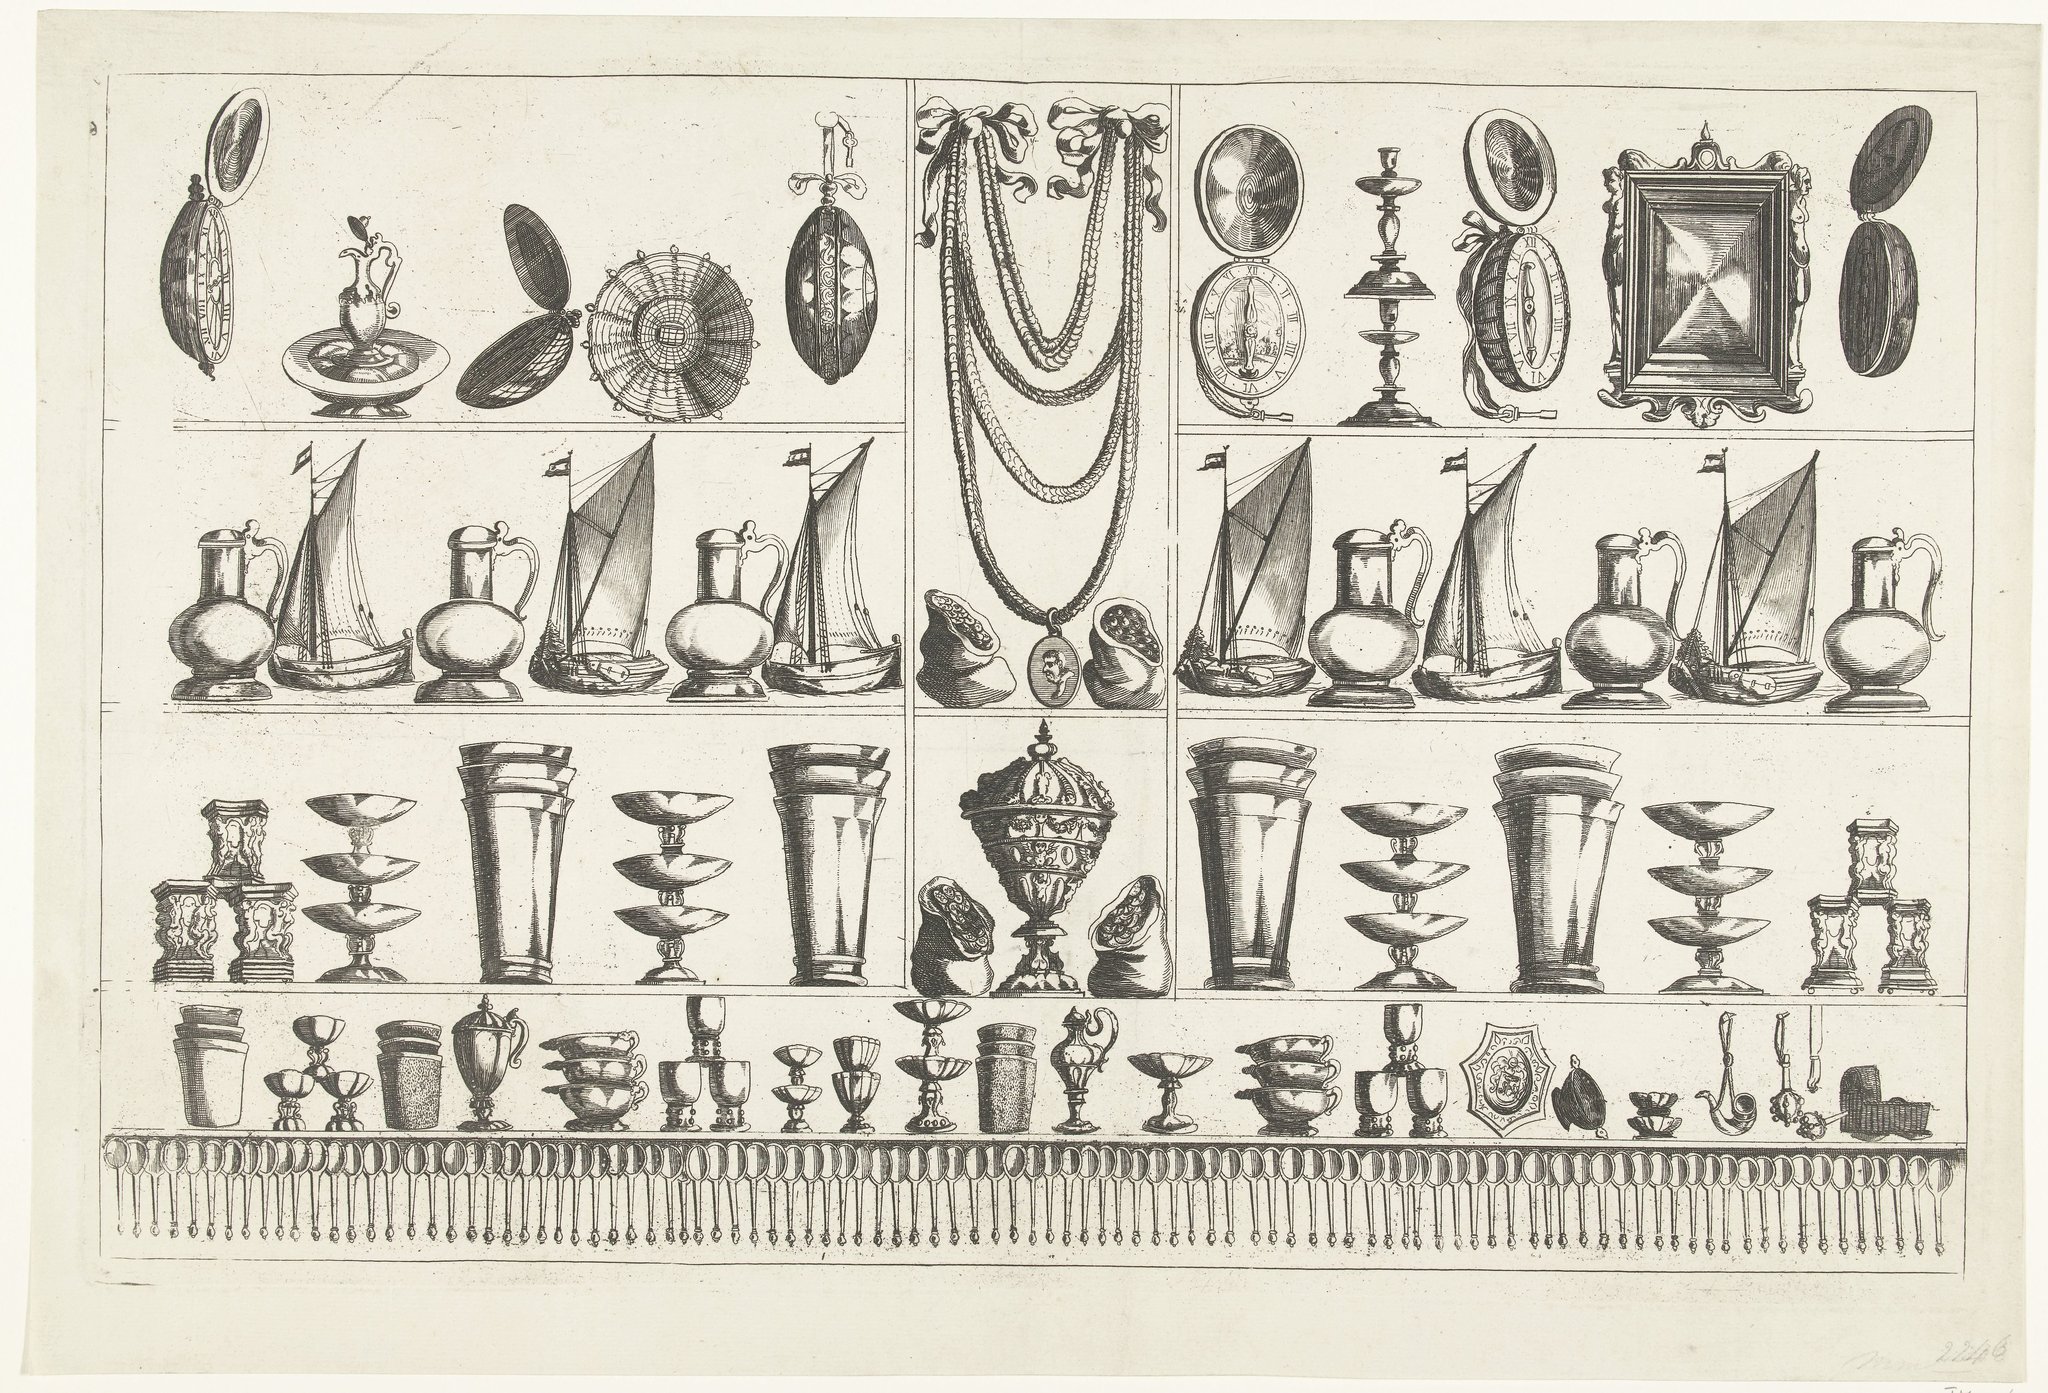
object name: print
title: De prijzen in de loterij voor West-Terschelling, 1666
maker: Anonymous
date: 1666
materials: paper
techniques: etching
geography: northern netherlands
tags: raffle, lottery, holmes's bonfire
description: De te winnen prijzen in de loterij georganiseerd voor de hulpbehoevenden te West-Terschelling, na de brandstichting door de Engelse troepen onder kapitein Robert Holmes, 19-20 augustus 1666. De prijzen bestaan onder andere uit : lepels, kannen, bokalen, miniatuurscheepjes, horloges, kandelaars, een halsketting met medaillon en zakken met geld.